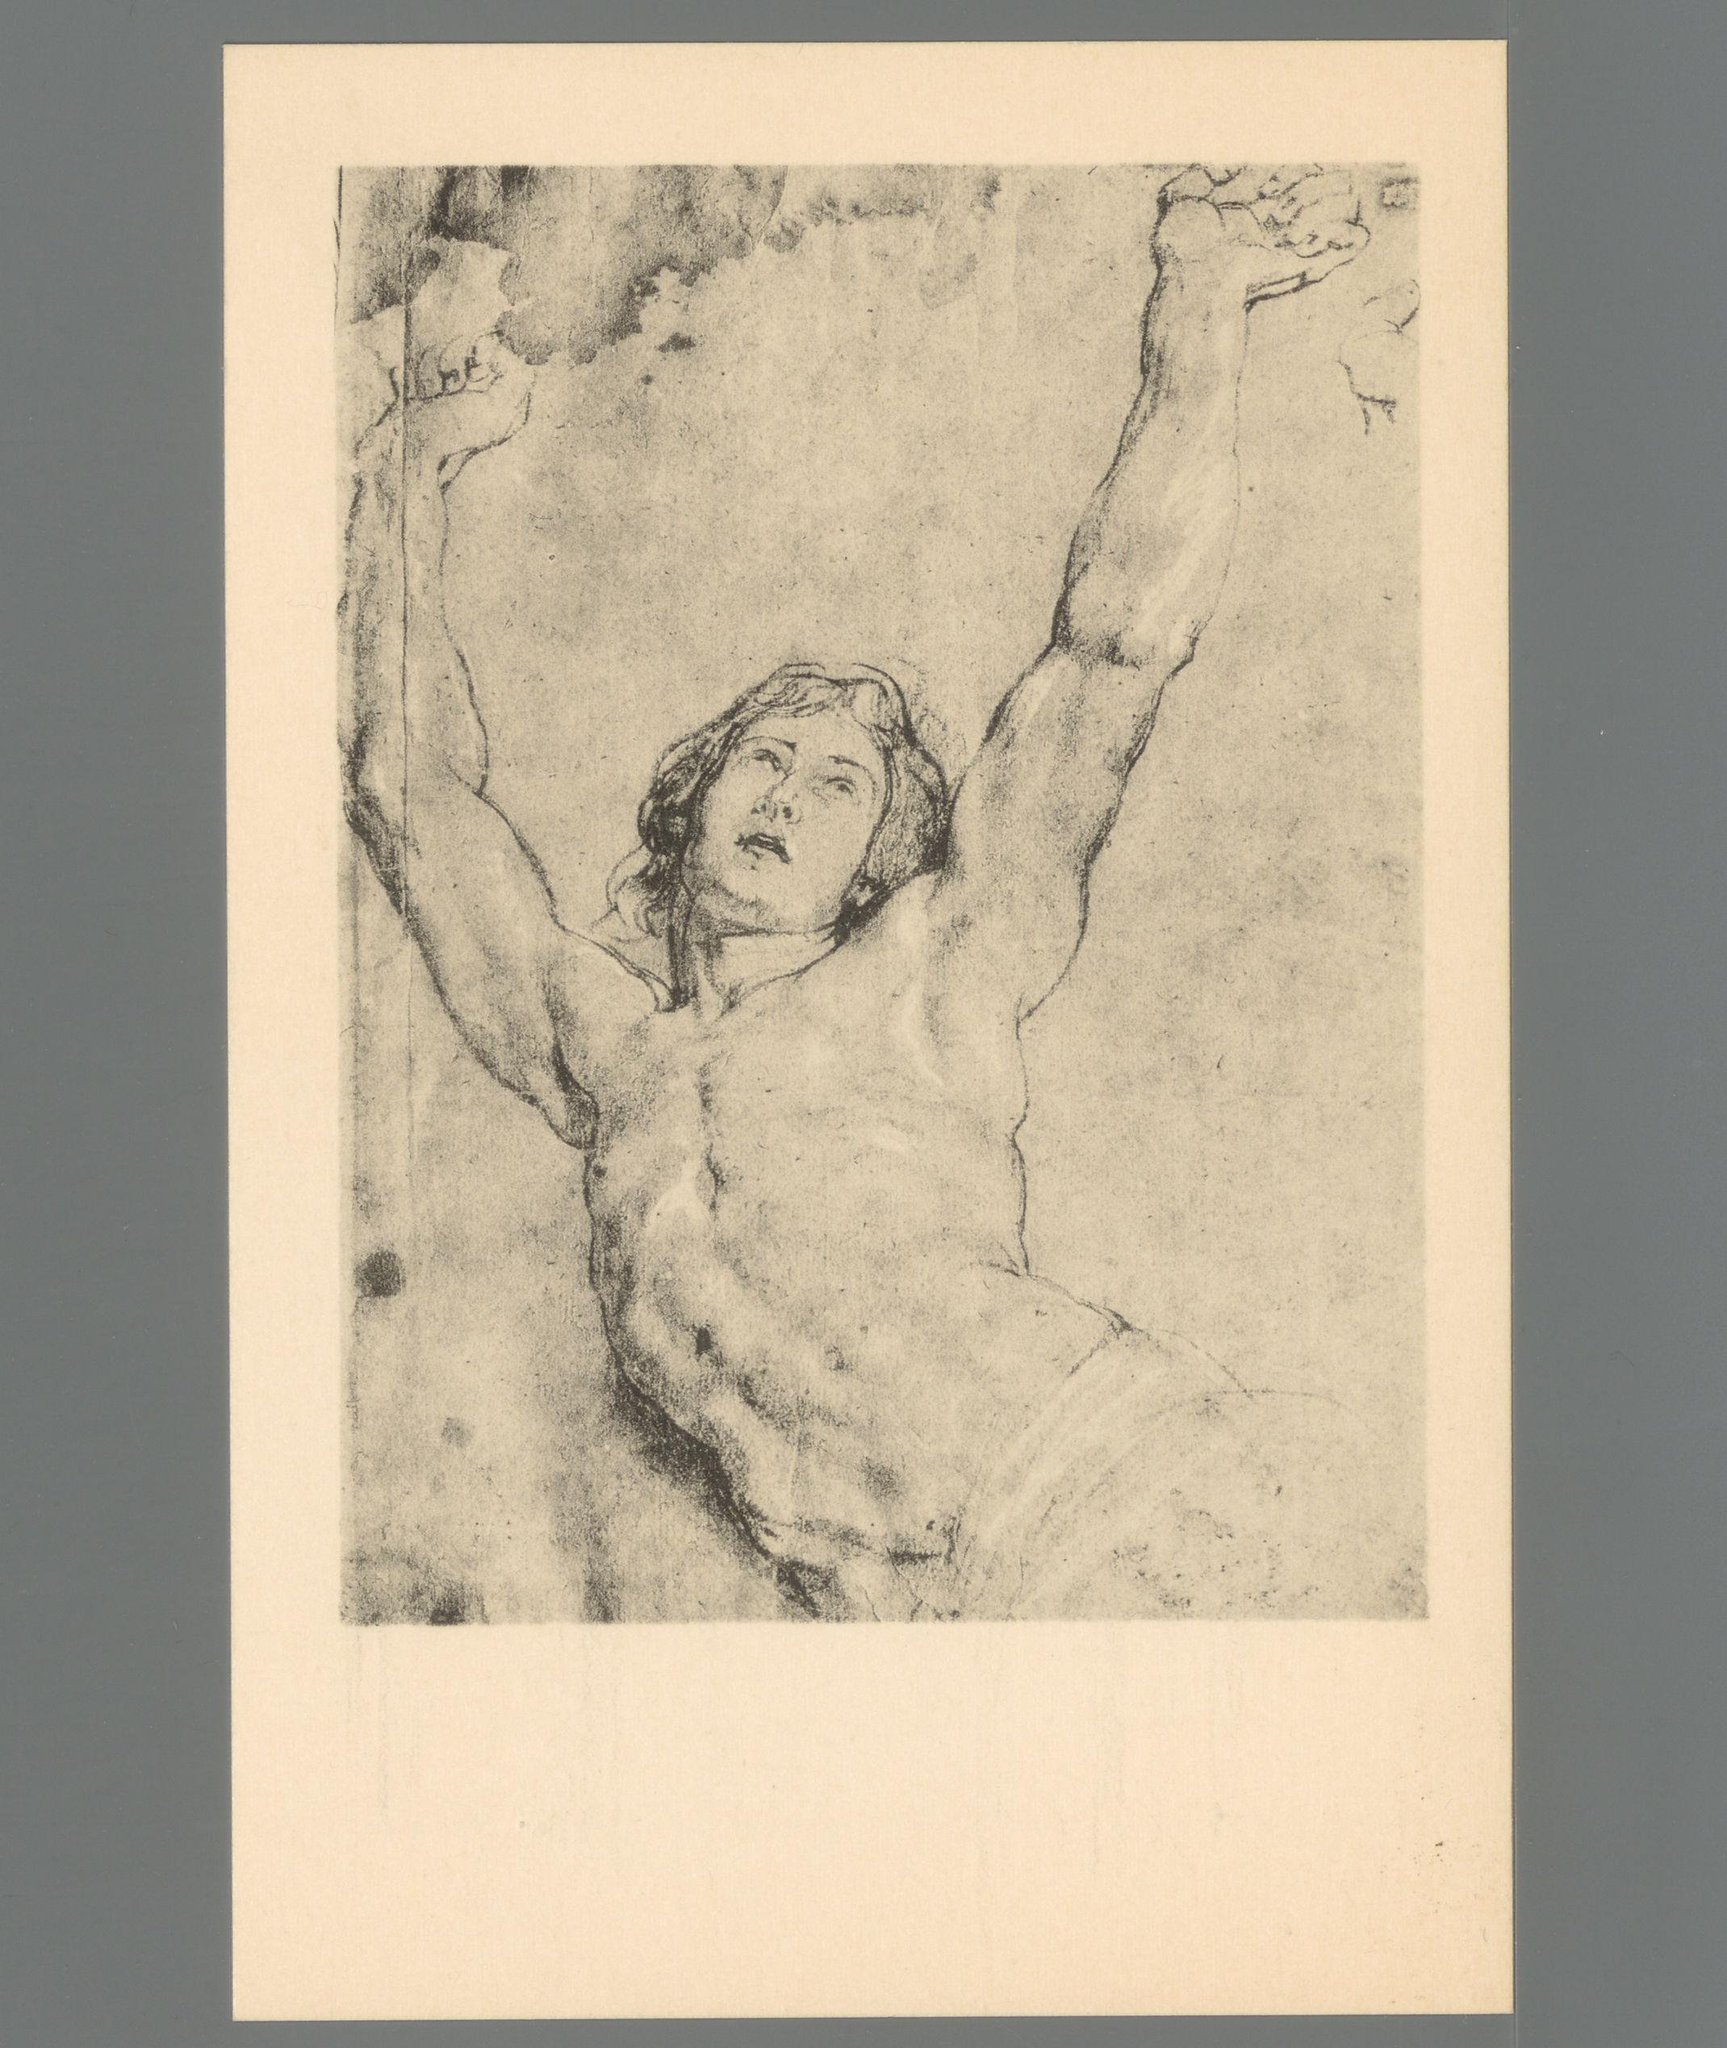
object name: photomechanical print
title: Study for the Erection of the Cross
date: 1949-1950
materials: cardboard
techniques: photograph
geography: cambridge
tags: adult man, arms raised, with fingers closed